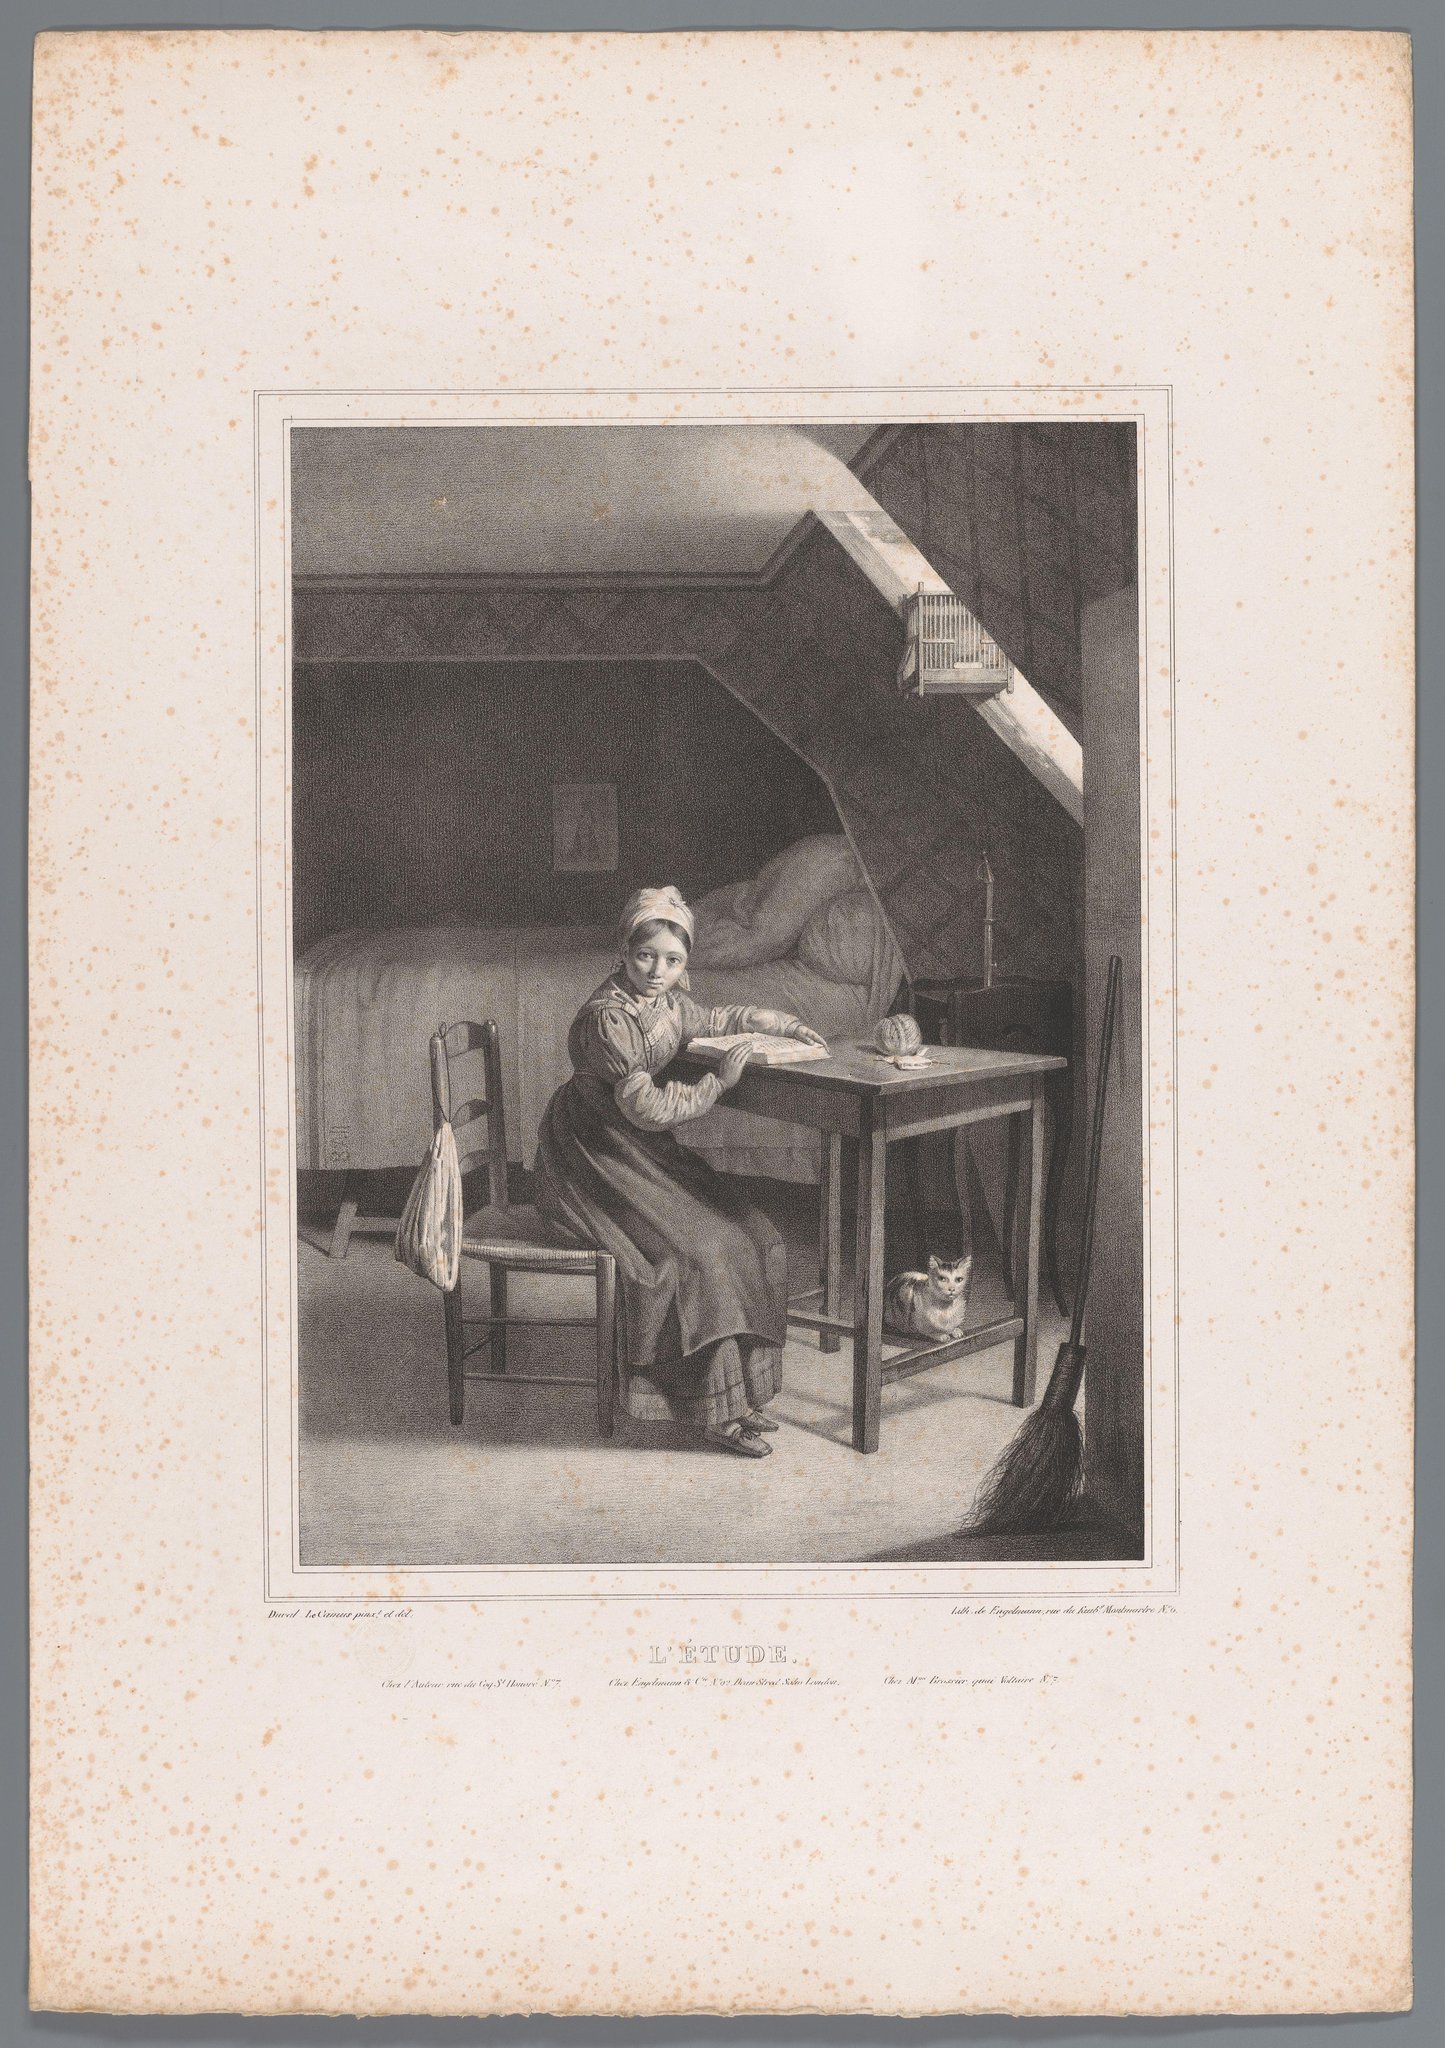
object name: print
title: L'Étude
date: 1829-1833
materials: paper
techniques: lithograph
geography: paris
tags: reading, child (at home) - aa - girl, bedroom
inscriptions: collector's mark: Lugt 2228a, check stamp: Lugt 5290, stamp: Lugt 5292